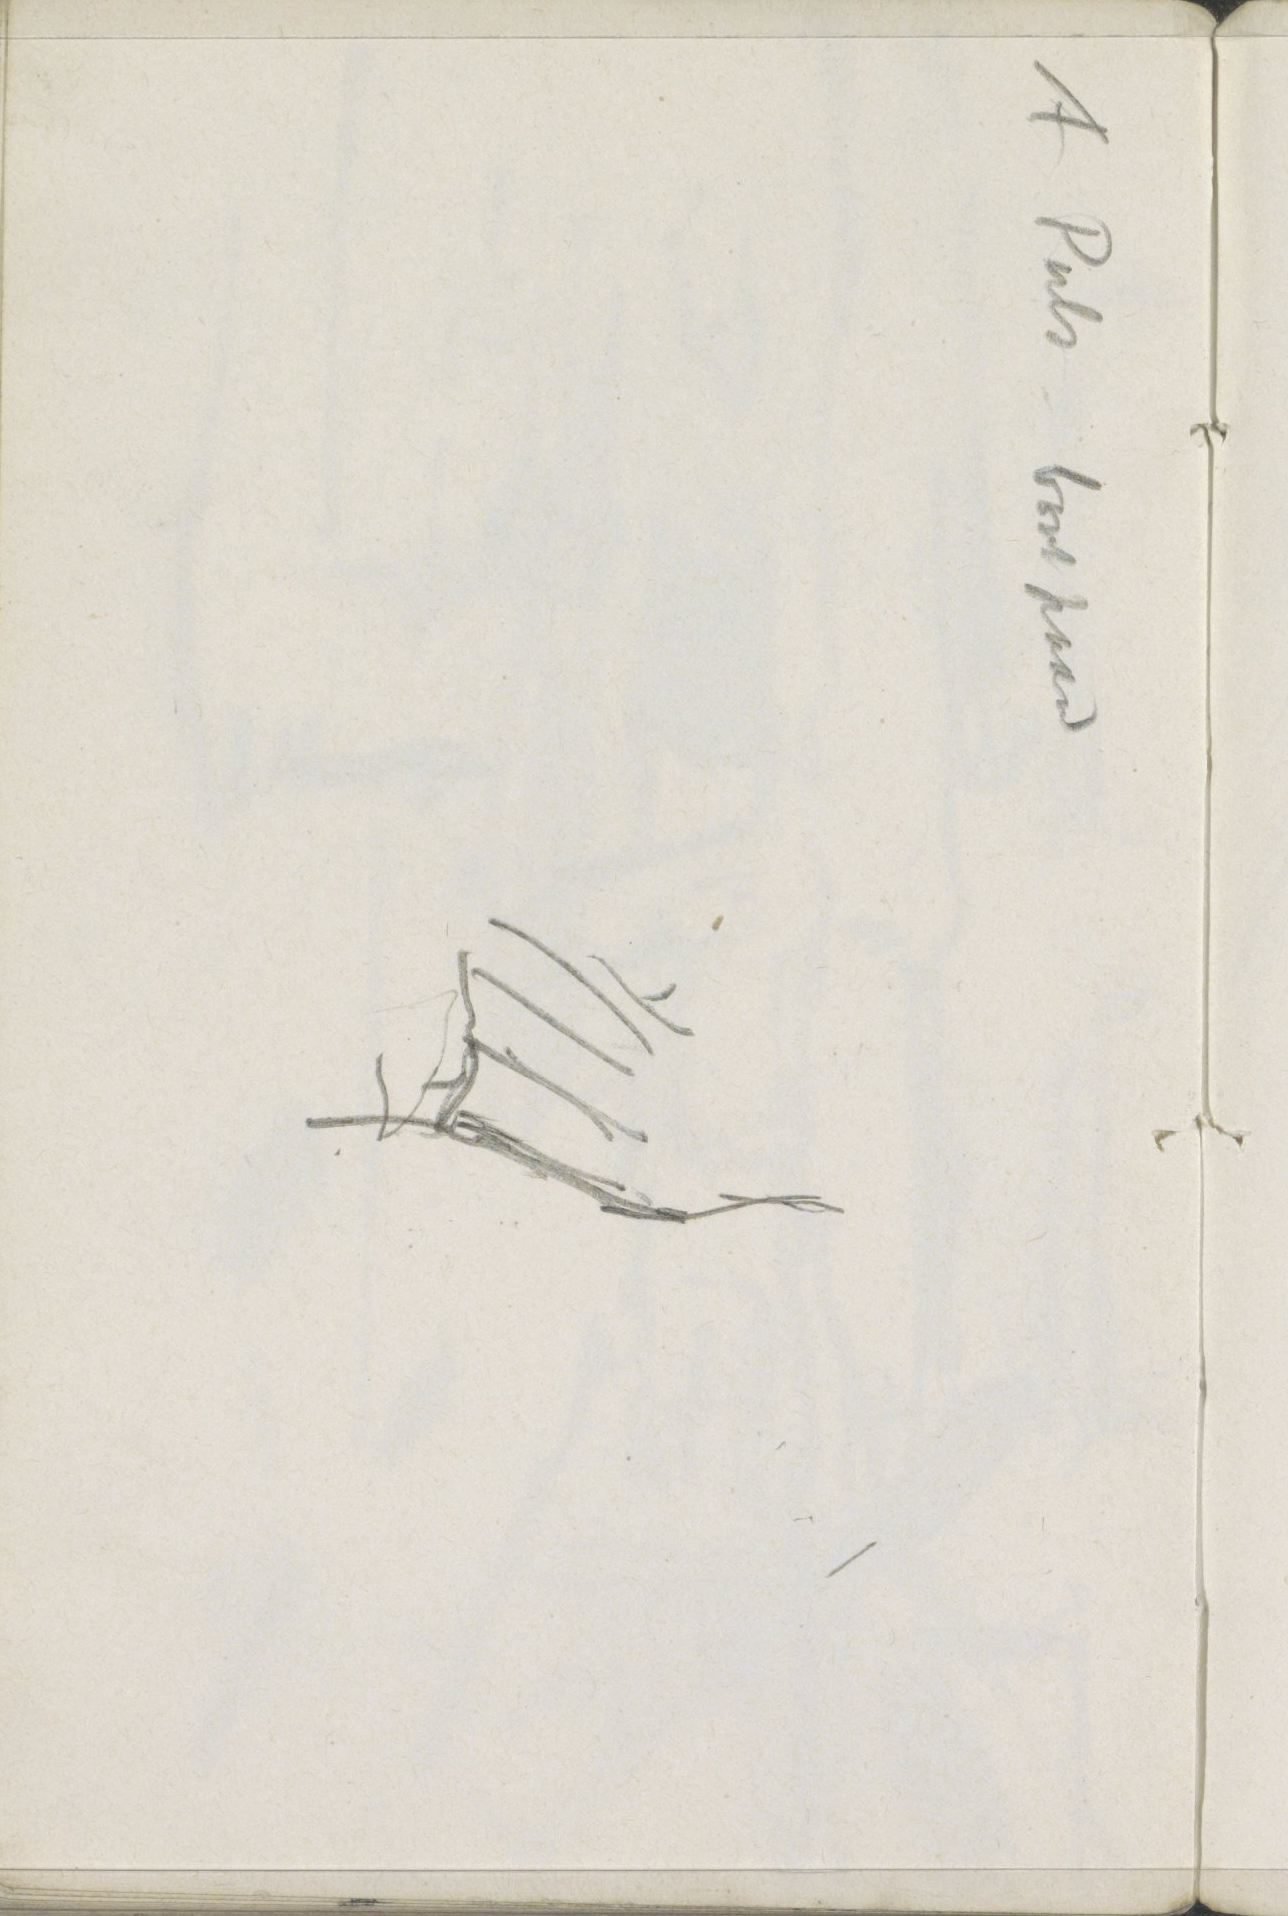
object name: sketchbook leaf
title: Studie, mogelijk van een paard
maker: george hendrik breitner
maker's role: draughtsman, painter, print maker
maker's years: 1857-1923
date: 1917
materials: paper, pencil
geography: amsterdam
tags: horse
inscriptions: annotation: ‘A. Puls bont paard’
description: Pagina 79 uit een schetsboek met 44 bladen.